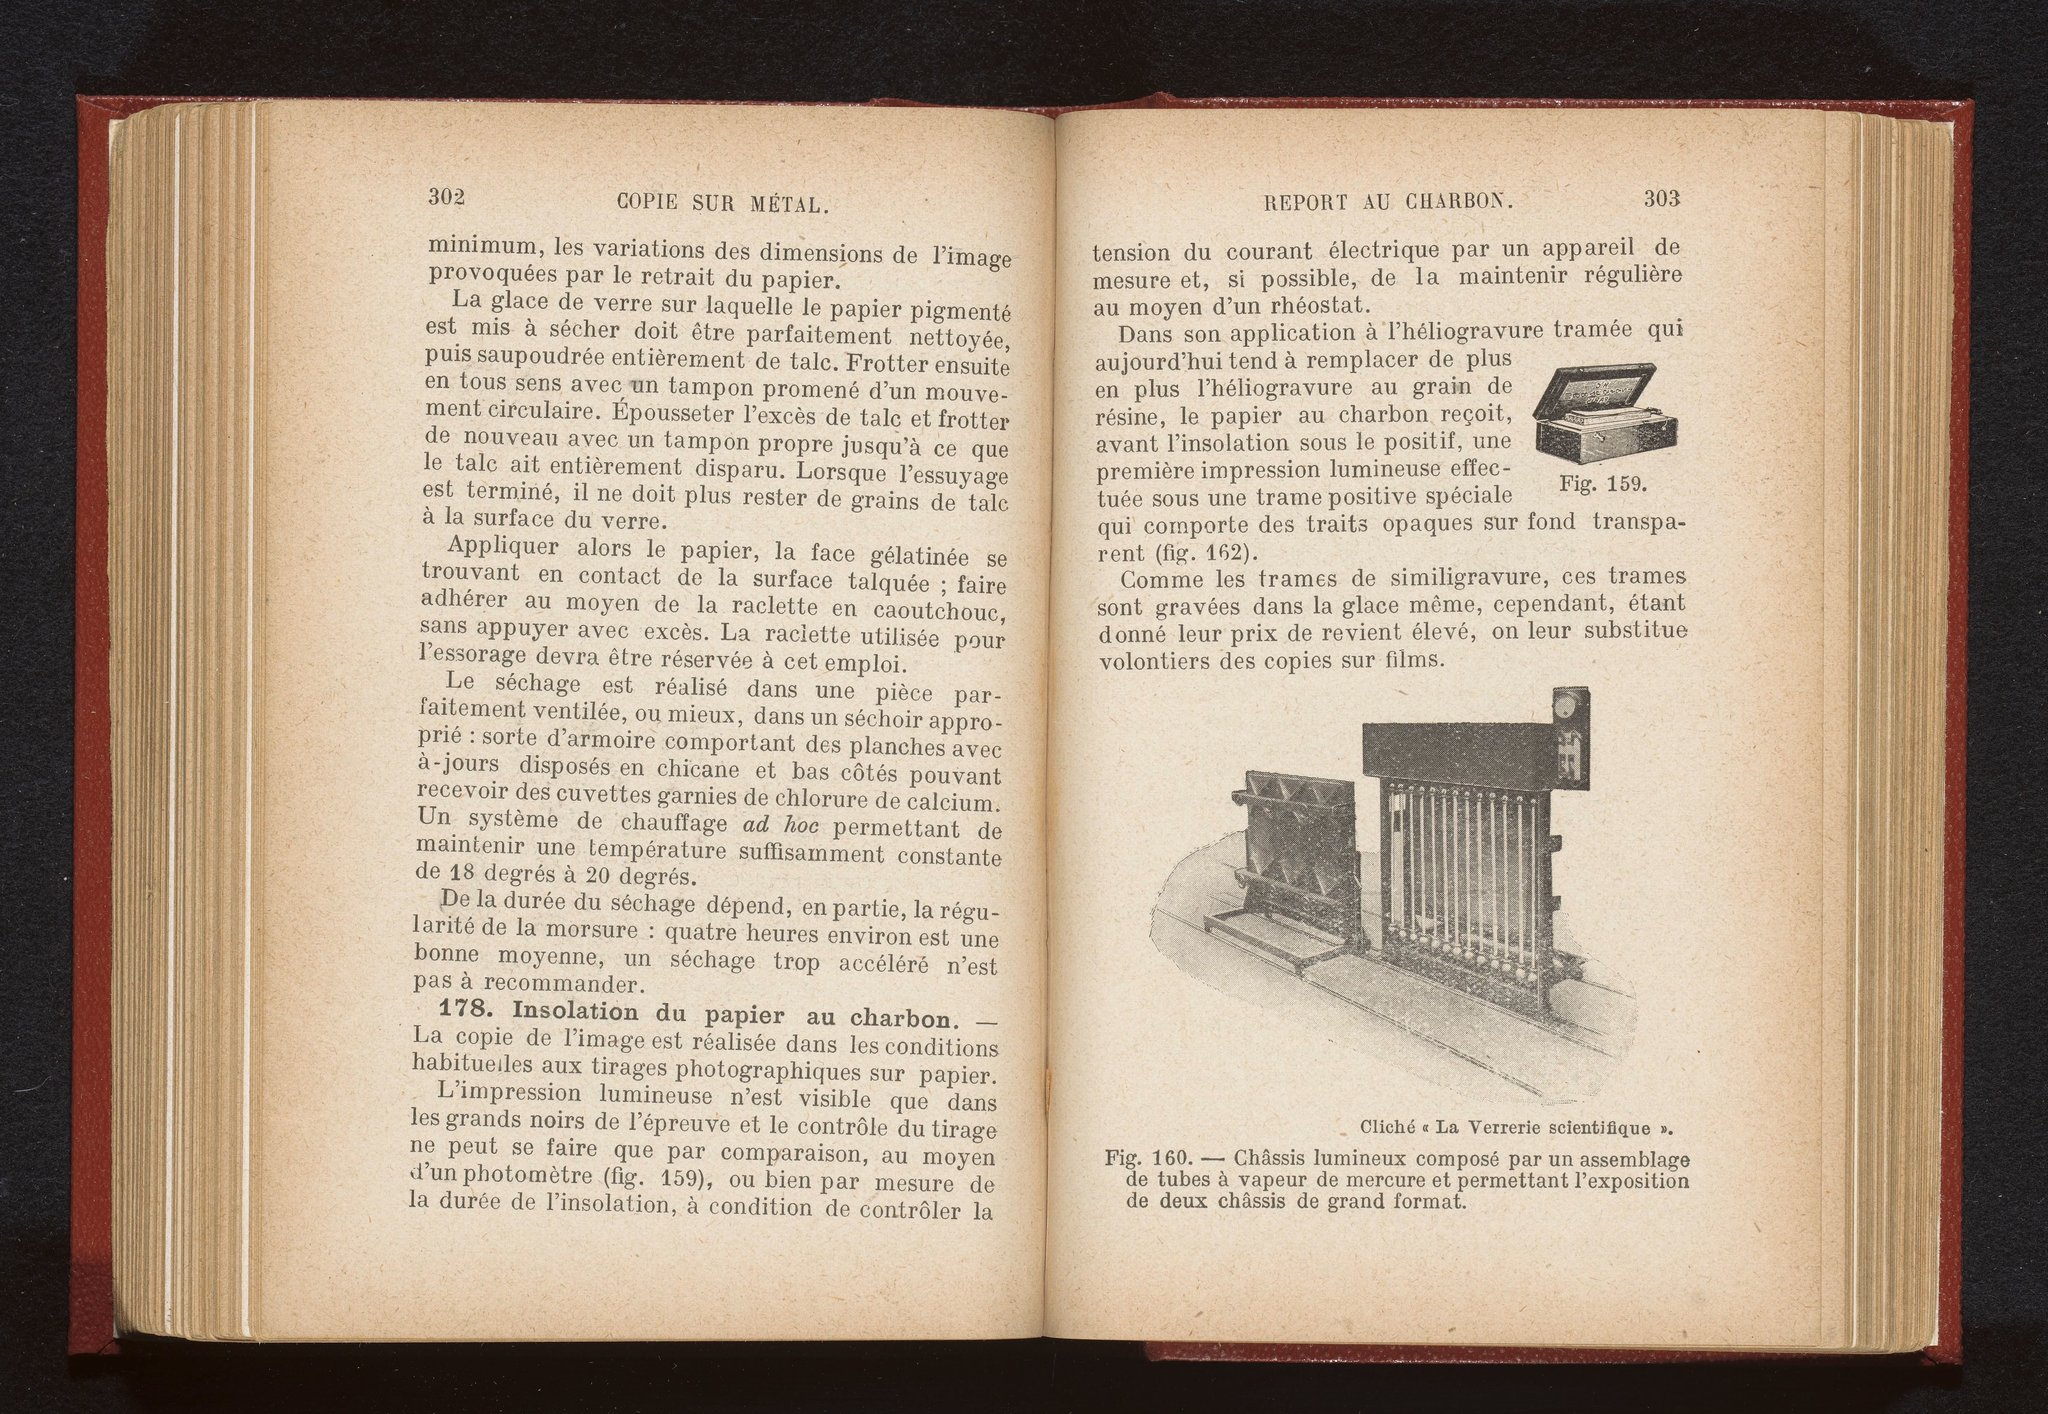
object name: photomechanical print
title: Lamp voor het maken van vermoedelijk kooldrukken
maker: Anonymous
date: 1922-1932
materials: paper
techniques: autotype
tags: photographic apparatus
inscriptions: number: ‘Fig. 160.’, name: ‘Cliché la Verrerie scientifique’